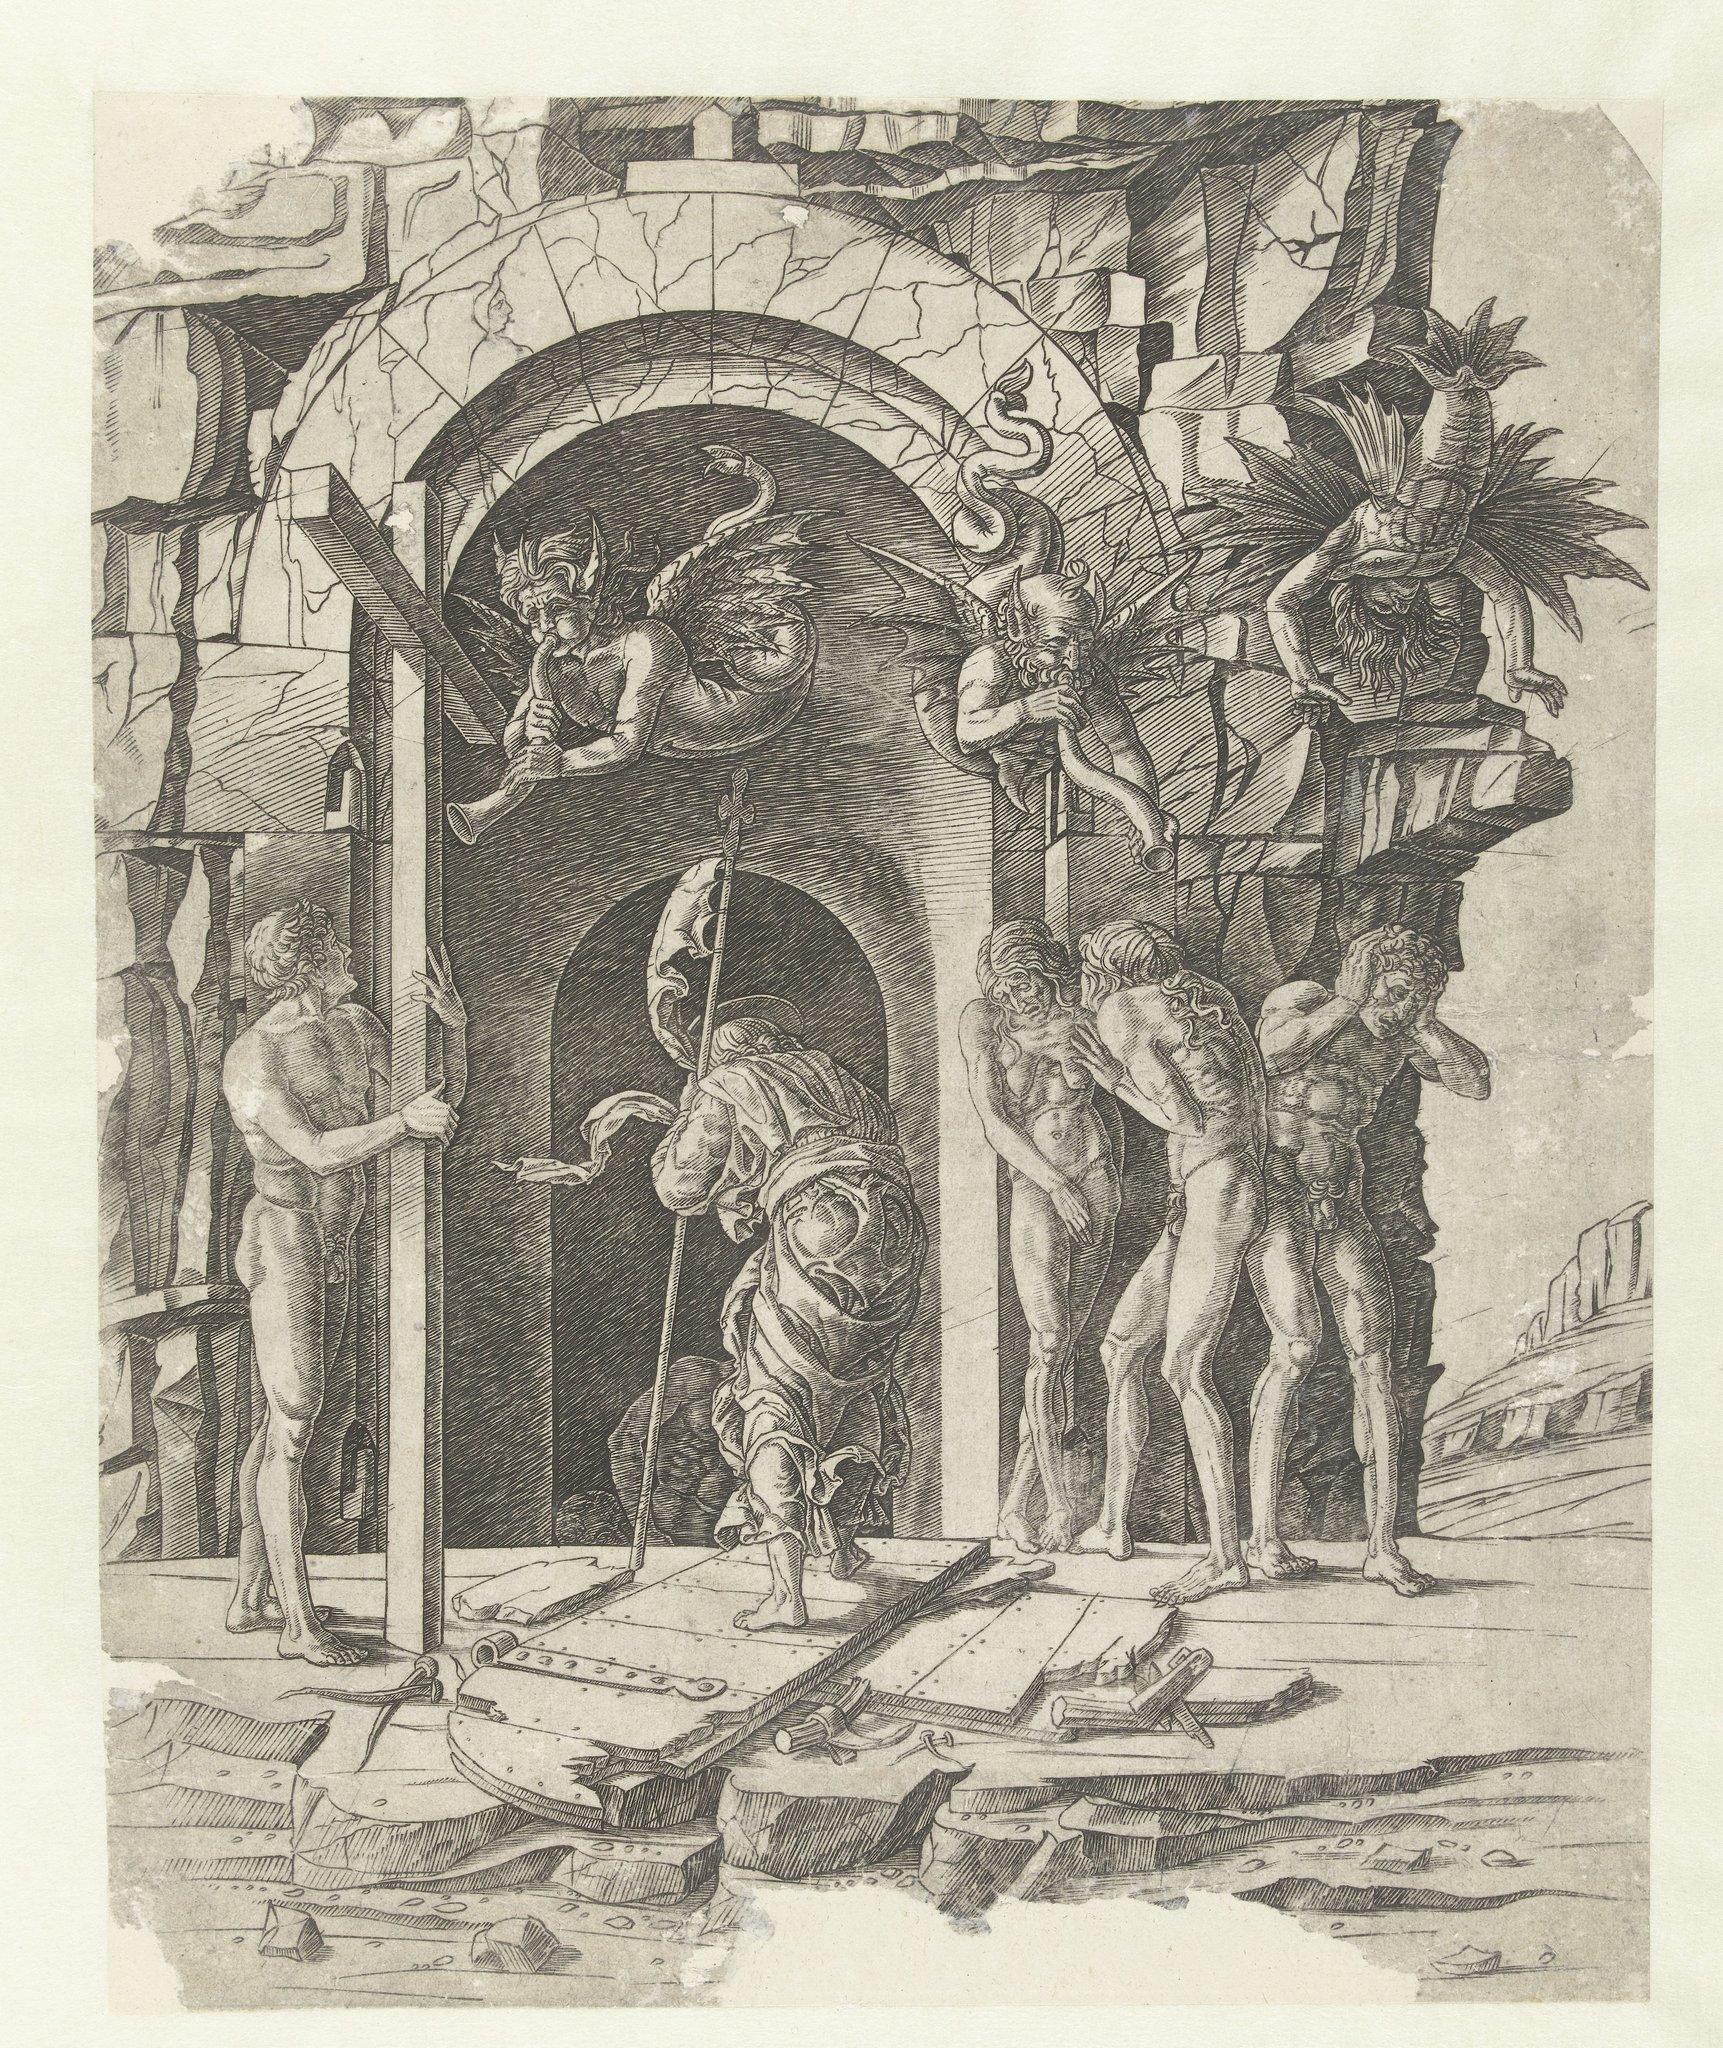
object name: print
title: Christus daalt af in voorgeborchte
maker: andrea mantegna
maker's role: print maker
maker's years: 1431-1506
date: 1475-1480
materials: paper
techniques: engraving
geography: italy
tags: christ enters hell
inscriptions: collector's mark: Lugt 240, collector's mark: Lugt 2228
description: De voorstelling lijkt gebaseerd op een scène uit een Passie serie van Andrea Mantegna (zie documentatie). Dit blad is zwaar beschadigd.